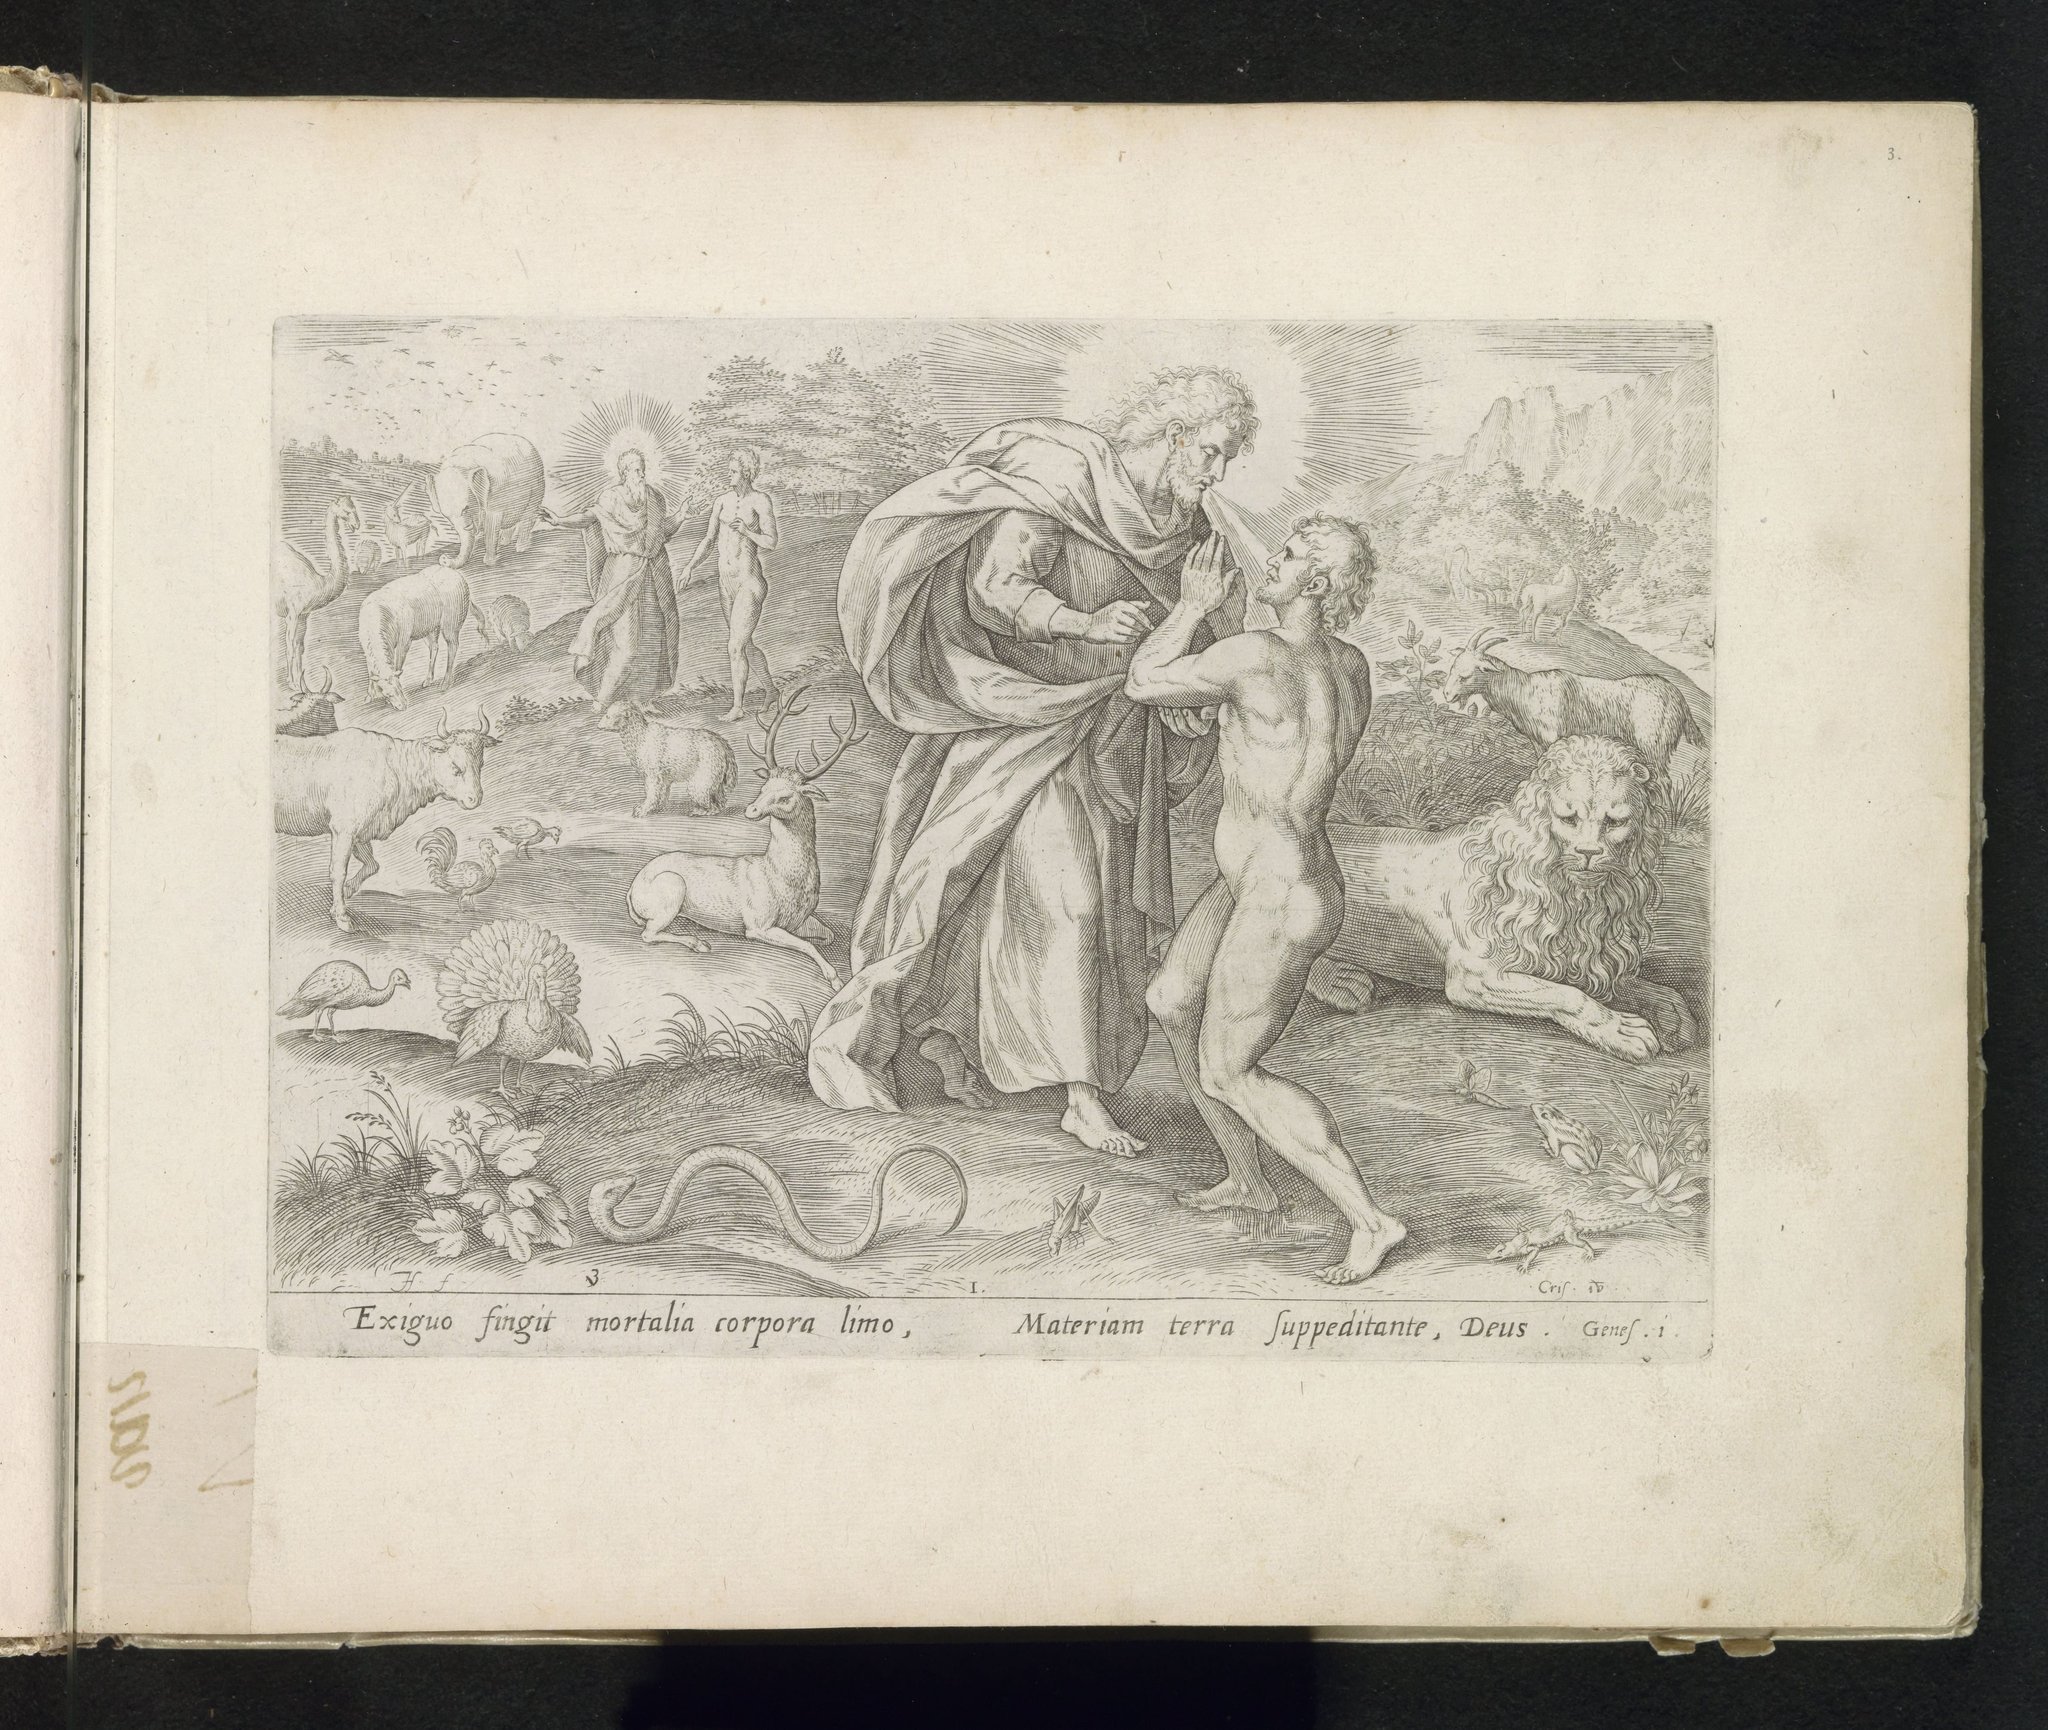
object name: print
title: Schepping van Adam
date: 1585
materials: paper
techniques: engraving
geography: antwerp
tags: god speaks to adam, the man (adam) comes to life: usually god reaches out his hand or breathes life into his nostrils (+ god the father), animals, god the father as bearded old man, usually with crown or tiara or sceptre and/or globe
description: De zesde scheppingsdag: de schepping van Adam. Op de voorgrond staat God de Vader die de naakte Adam leven inblaast. Op de achtergrond geeft God Adam de opdracht om de dieren namen te geven. Onderaan een verwijzing naar de Bijbeltekst in het Latijn. Deze prent maakt deel uit van een album.